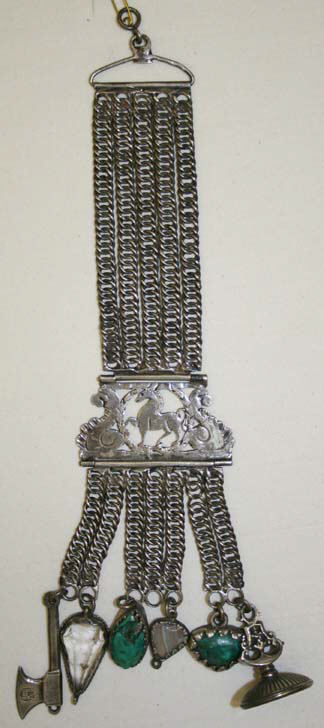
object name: fob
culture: german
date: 1767-1833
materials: metal, stone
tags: horses